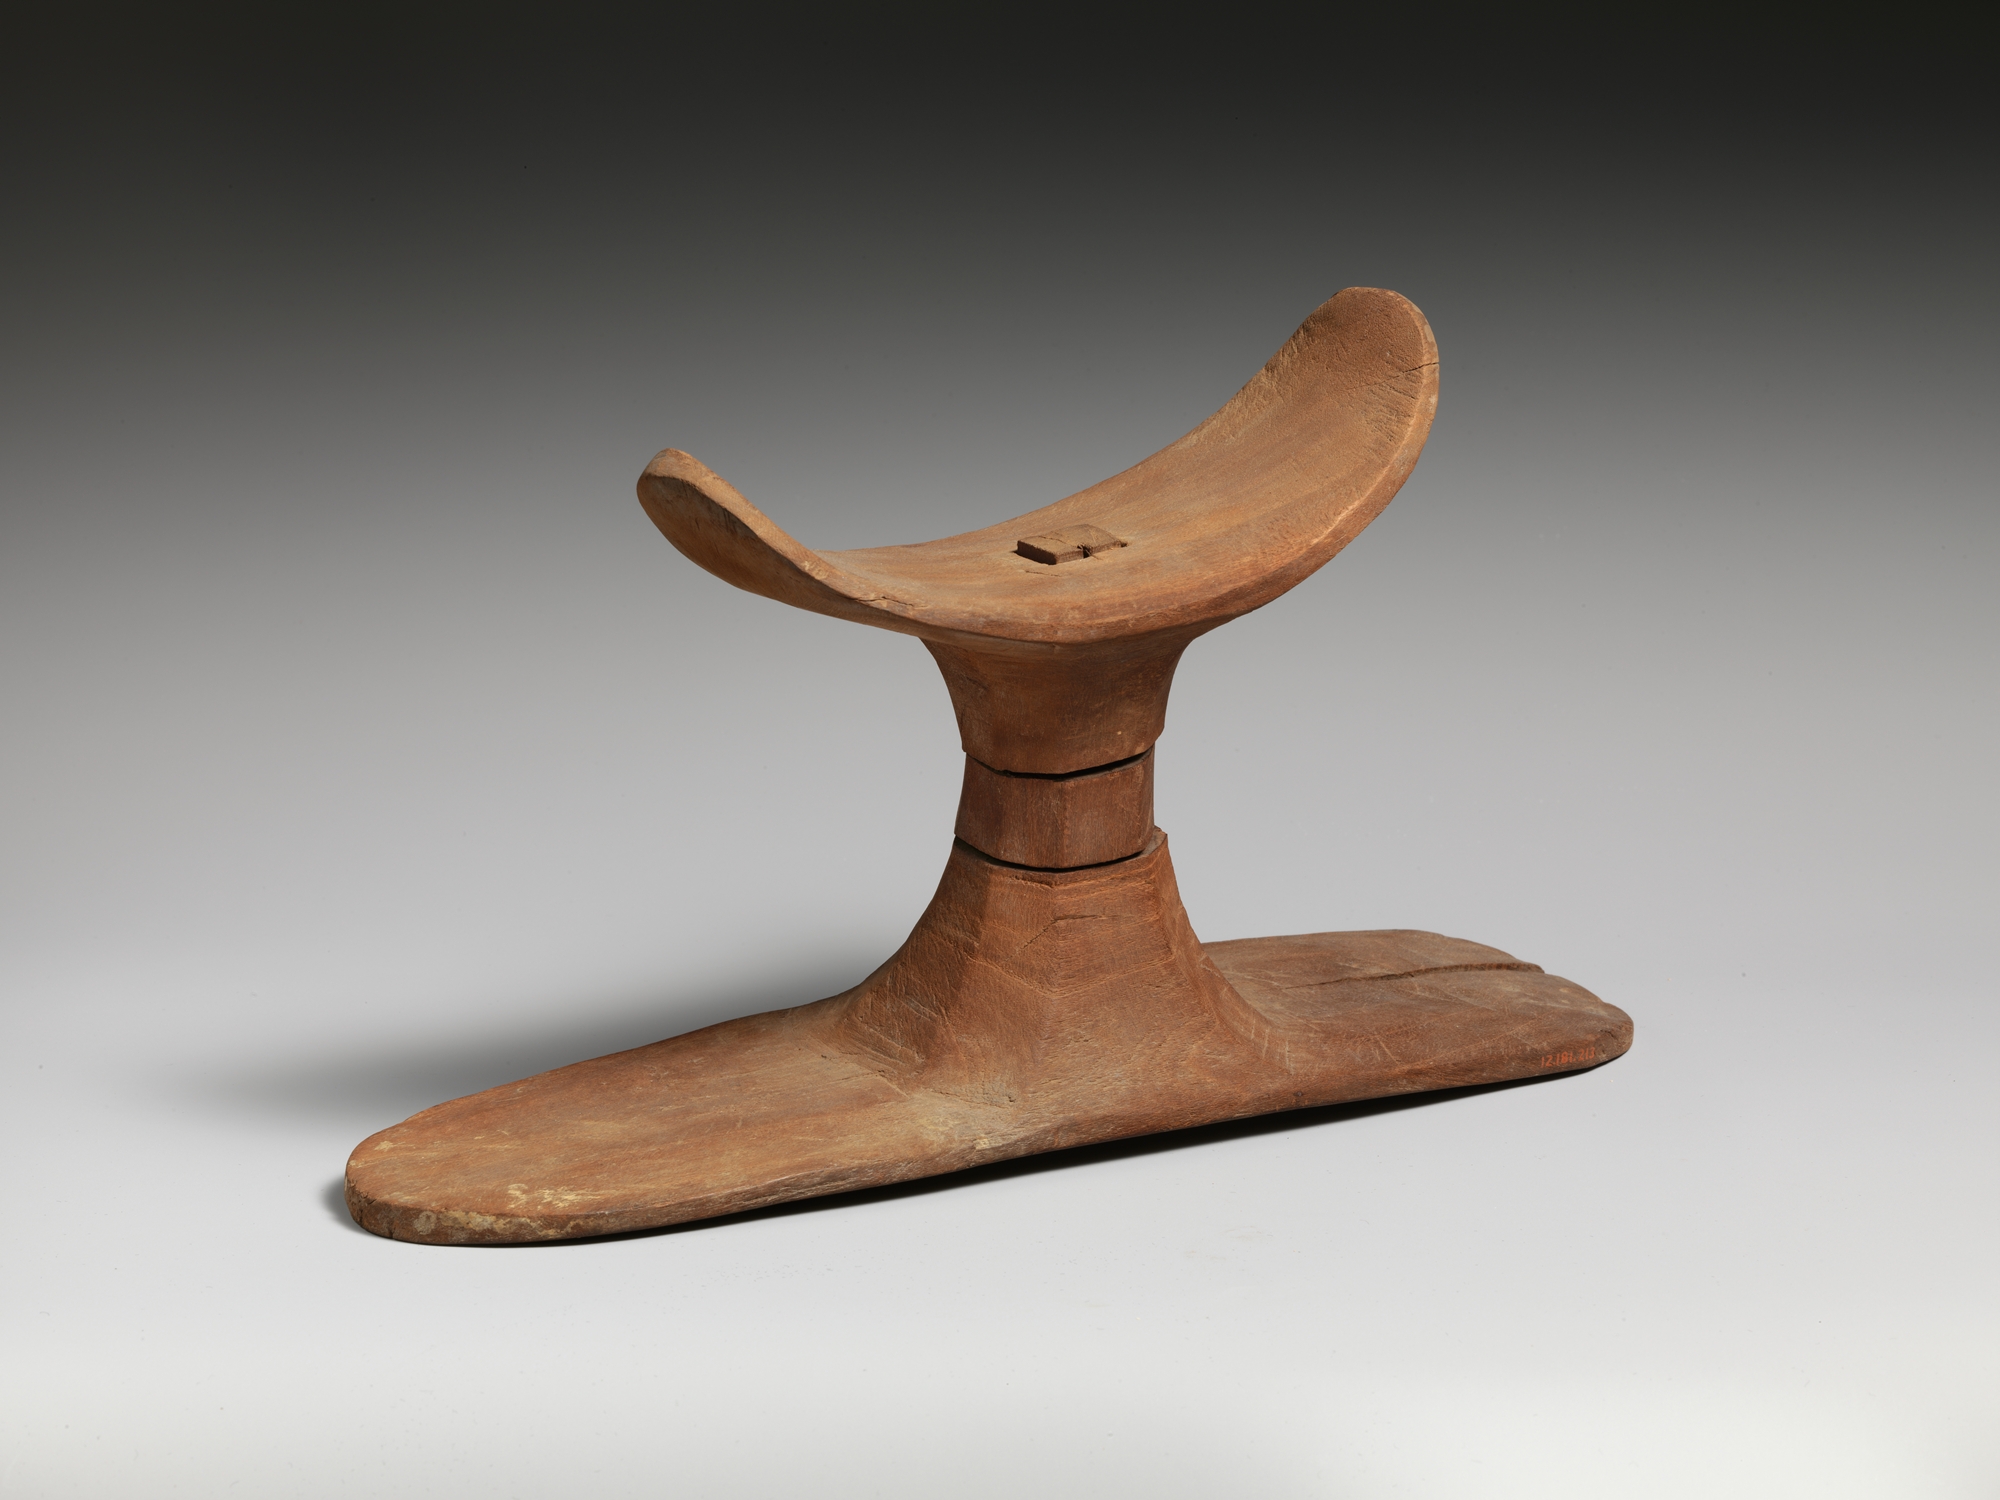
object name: headrest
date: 1570-1492 BCE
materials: wood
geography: egypt